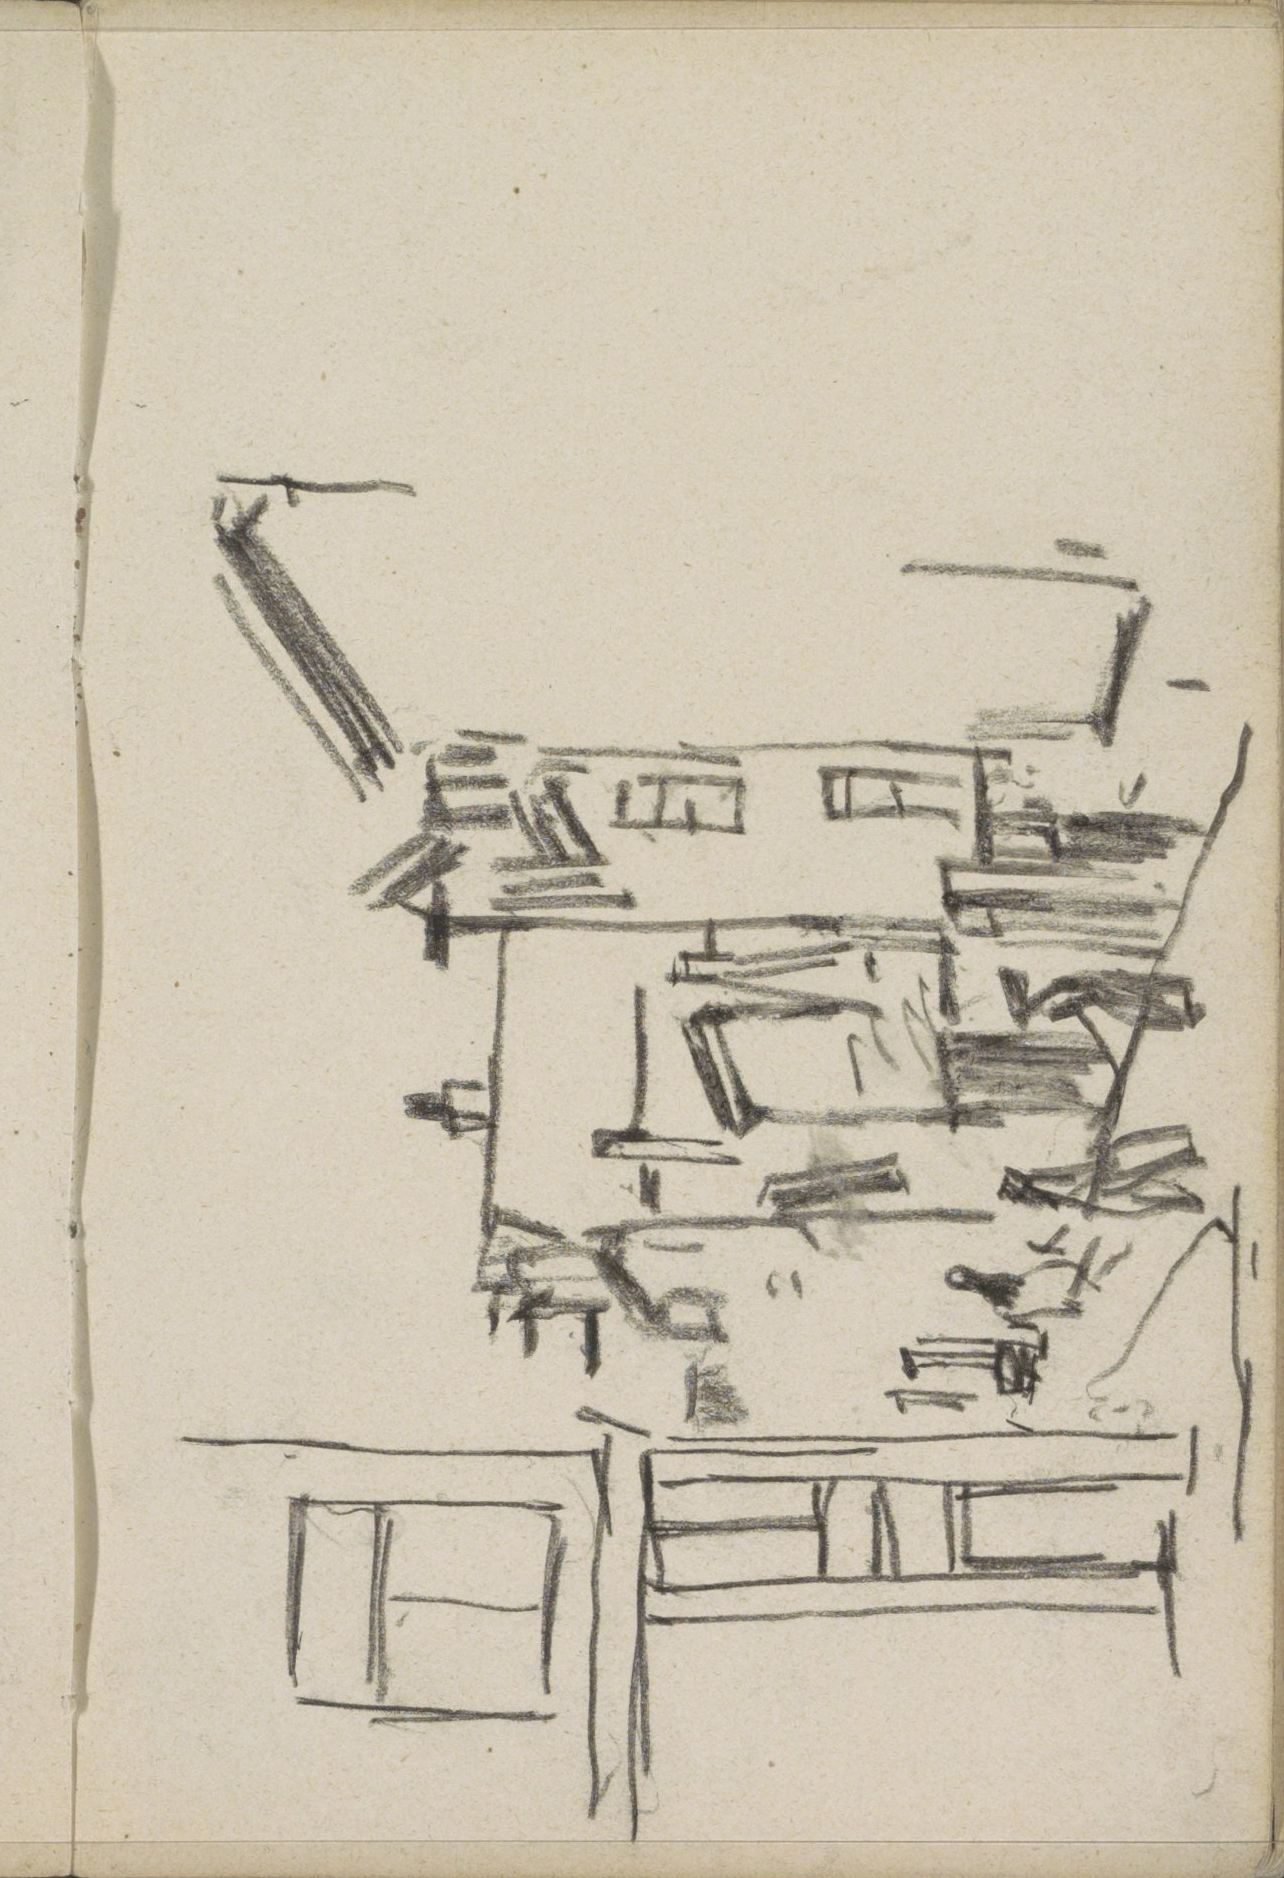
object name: sketchbook leaf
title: Gezicht in Amsterdam, mogelijk in de buurt van het Leidseplein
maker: george hendrik breitner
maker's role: draughtsman, painter, print maker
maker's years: 1857-1923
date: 1900-1923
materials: chalk, paper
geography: amsterdam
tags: urban housing, street (+ city(-scape) with figures, staffage)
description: Pagina 6 uit een schetsboek met 39 bladen.